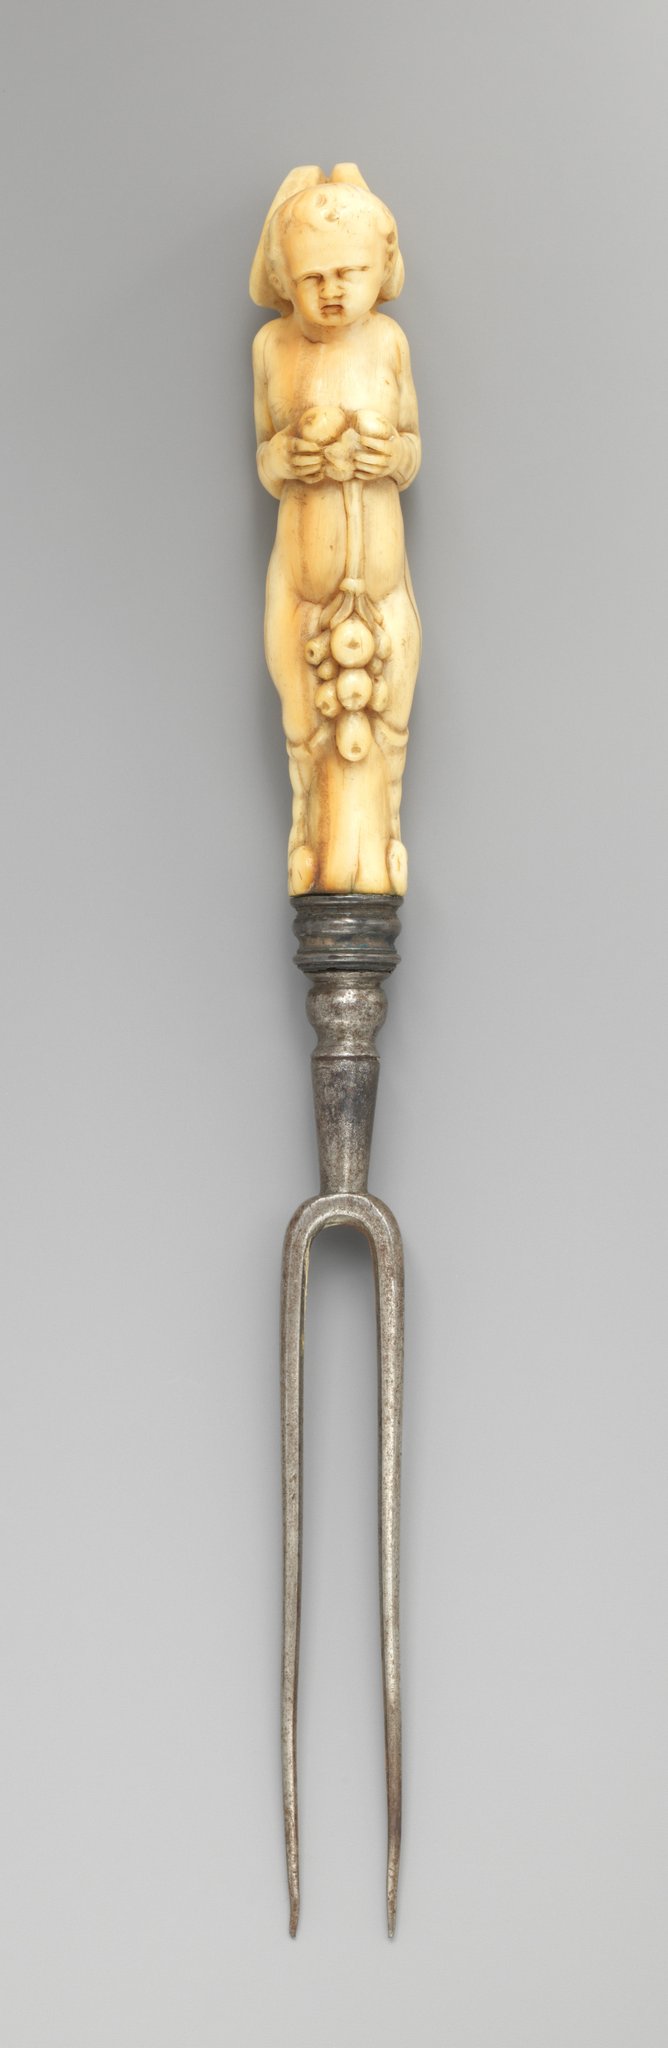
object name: fork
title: Fork with winged putto handle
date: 1601-1700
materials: ivory, steel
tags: putti